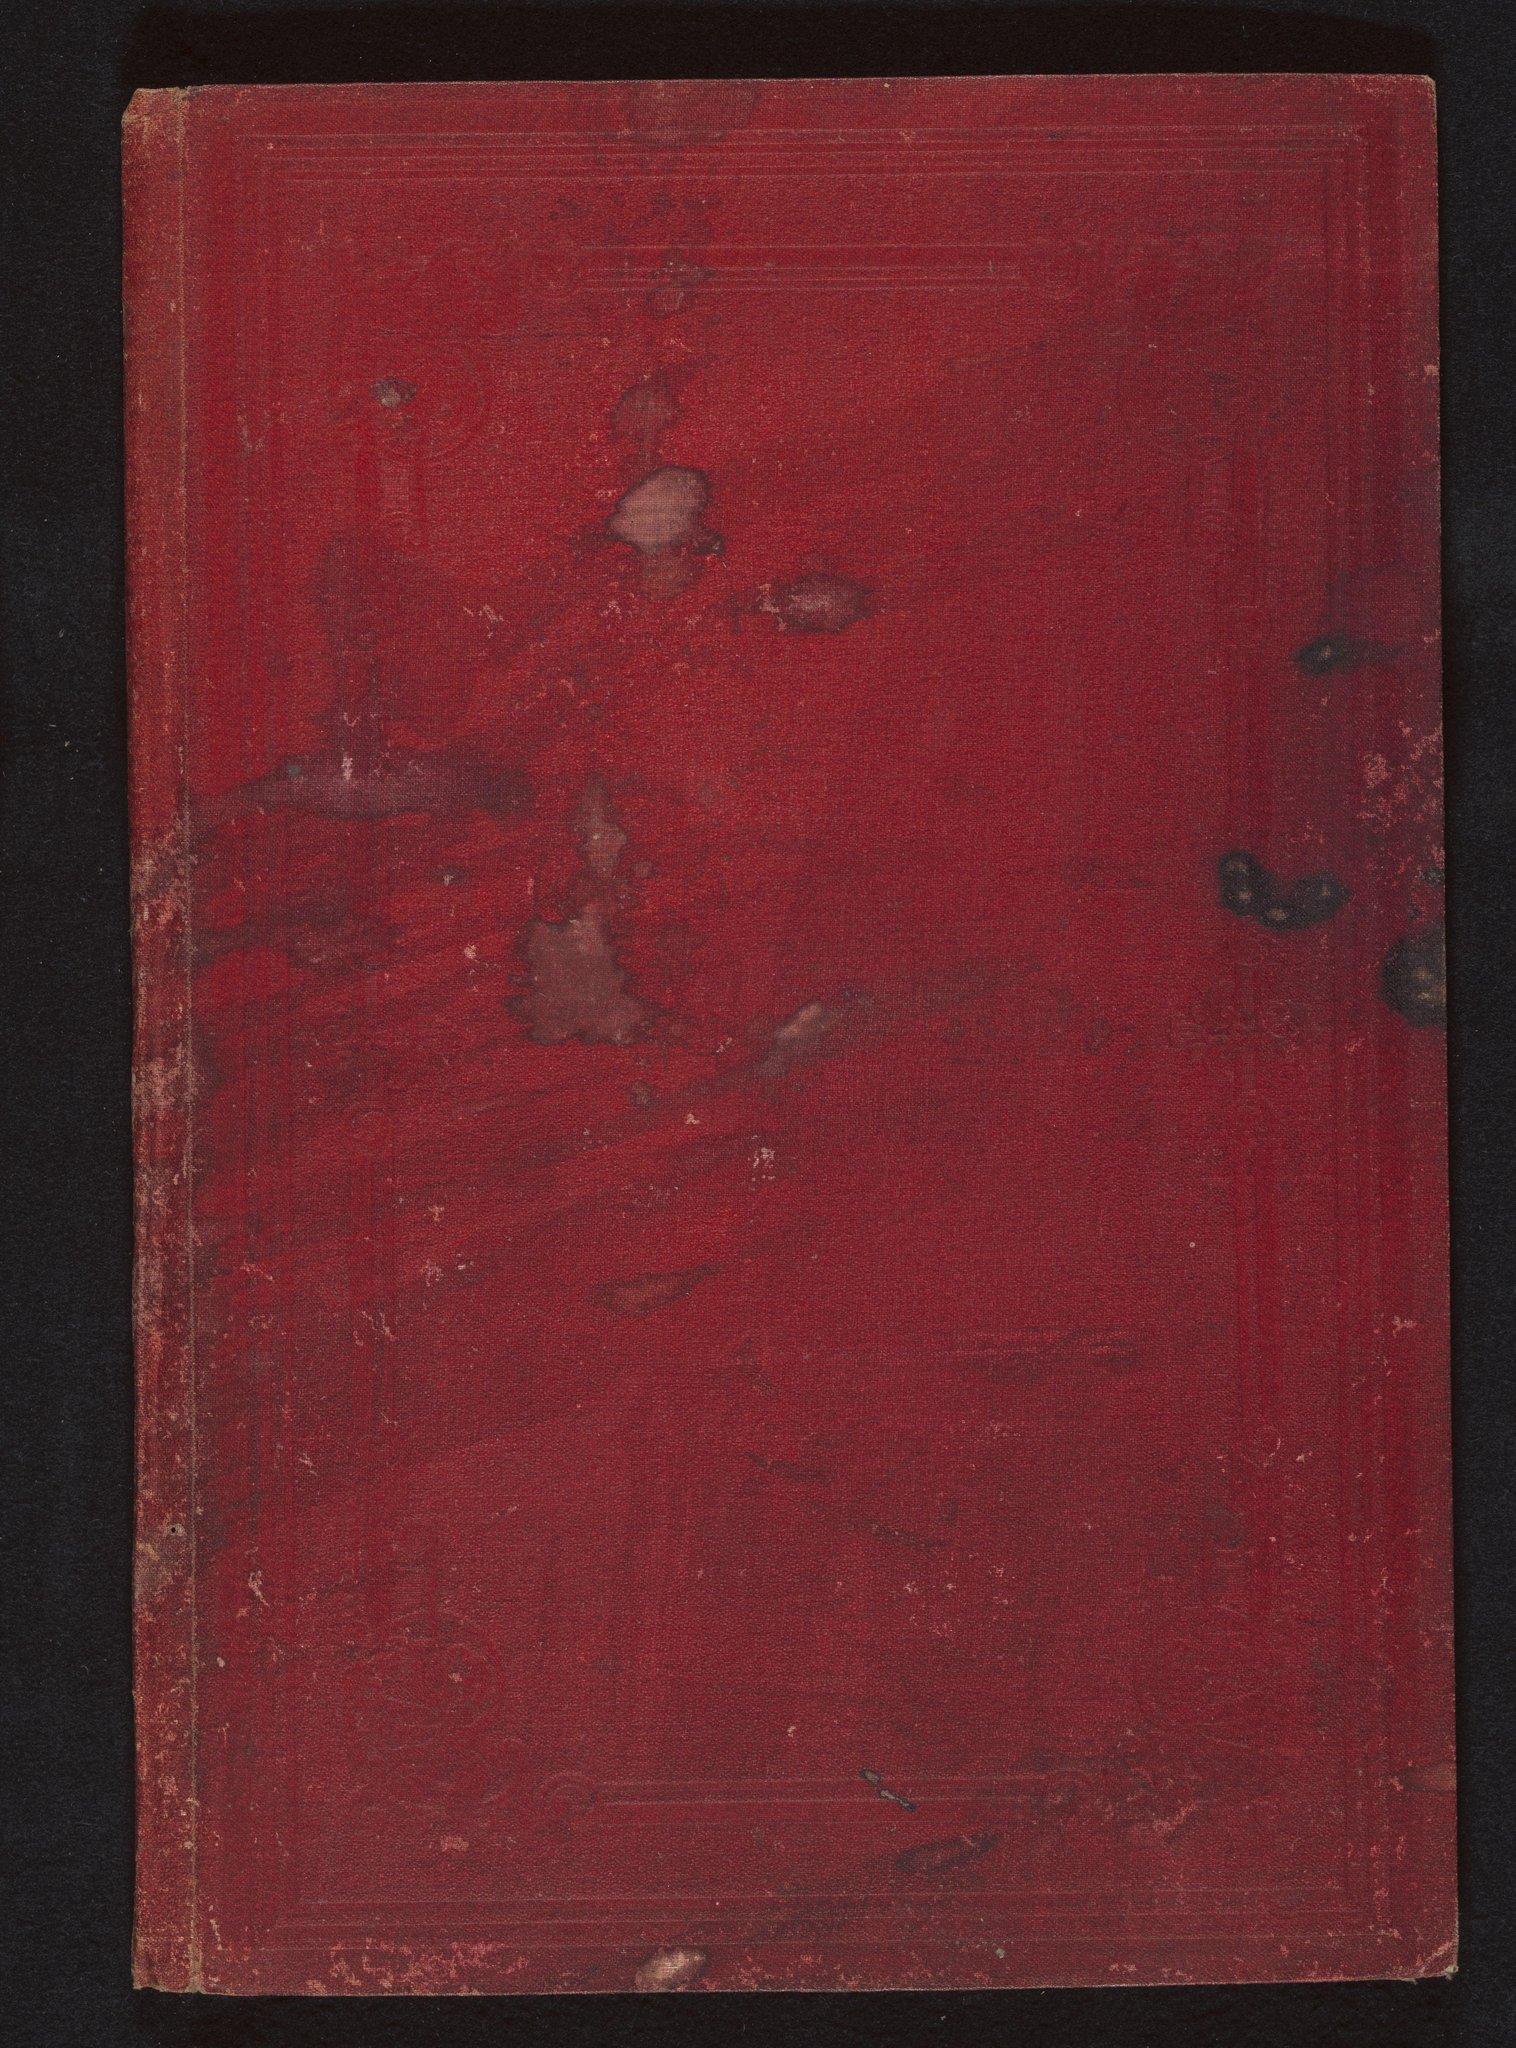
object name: prentrecueil, prentenalbum, prentalbum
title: Prentalbum met collages van uitgeknipte prenten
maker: Anonymous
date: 1870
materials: paper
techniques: bookbinding, engraving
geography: paris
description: Album met rode omslag en 32 bladen. Voorzien van uitgeknipte prenten, vermoedelijk afkomstig uit 19e-eeuwse tijdschiften, in een decoratieve, vaak symmetrische compositie.